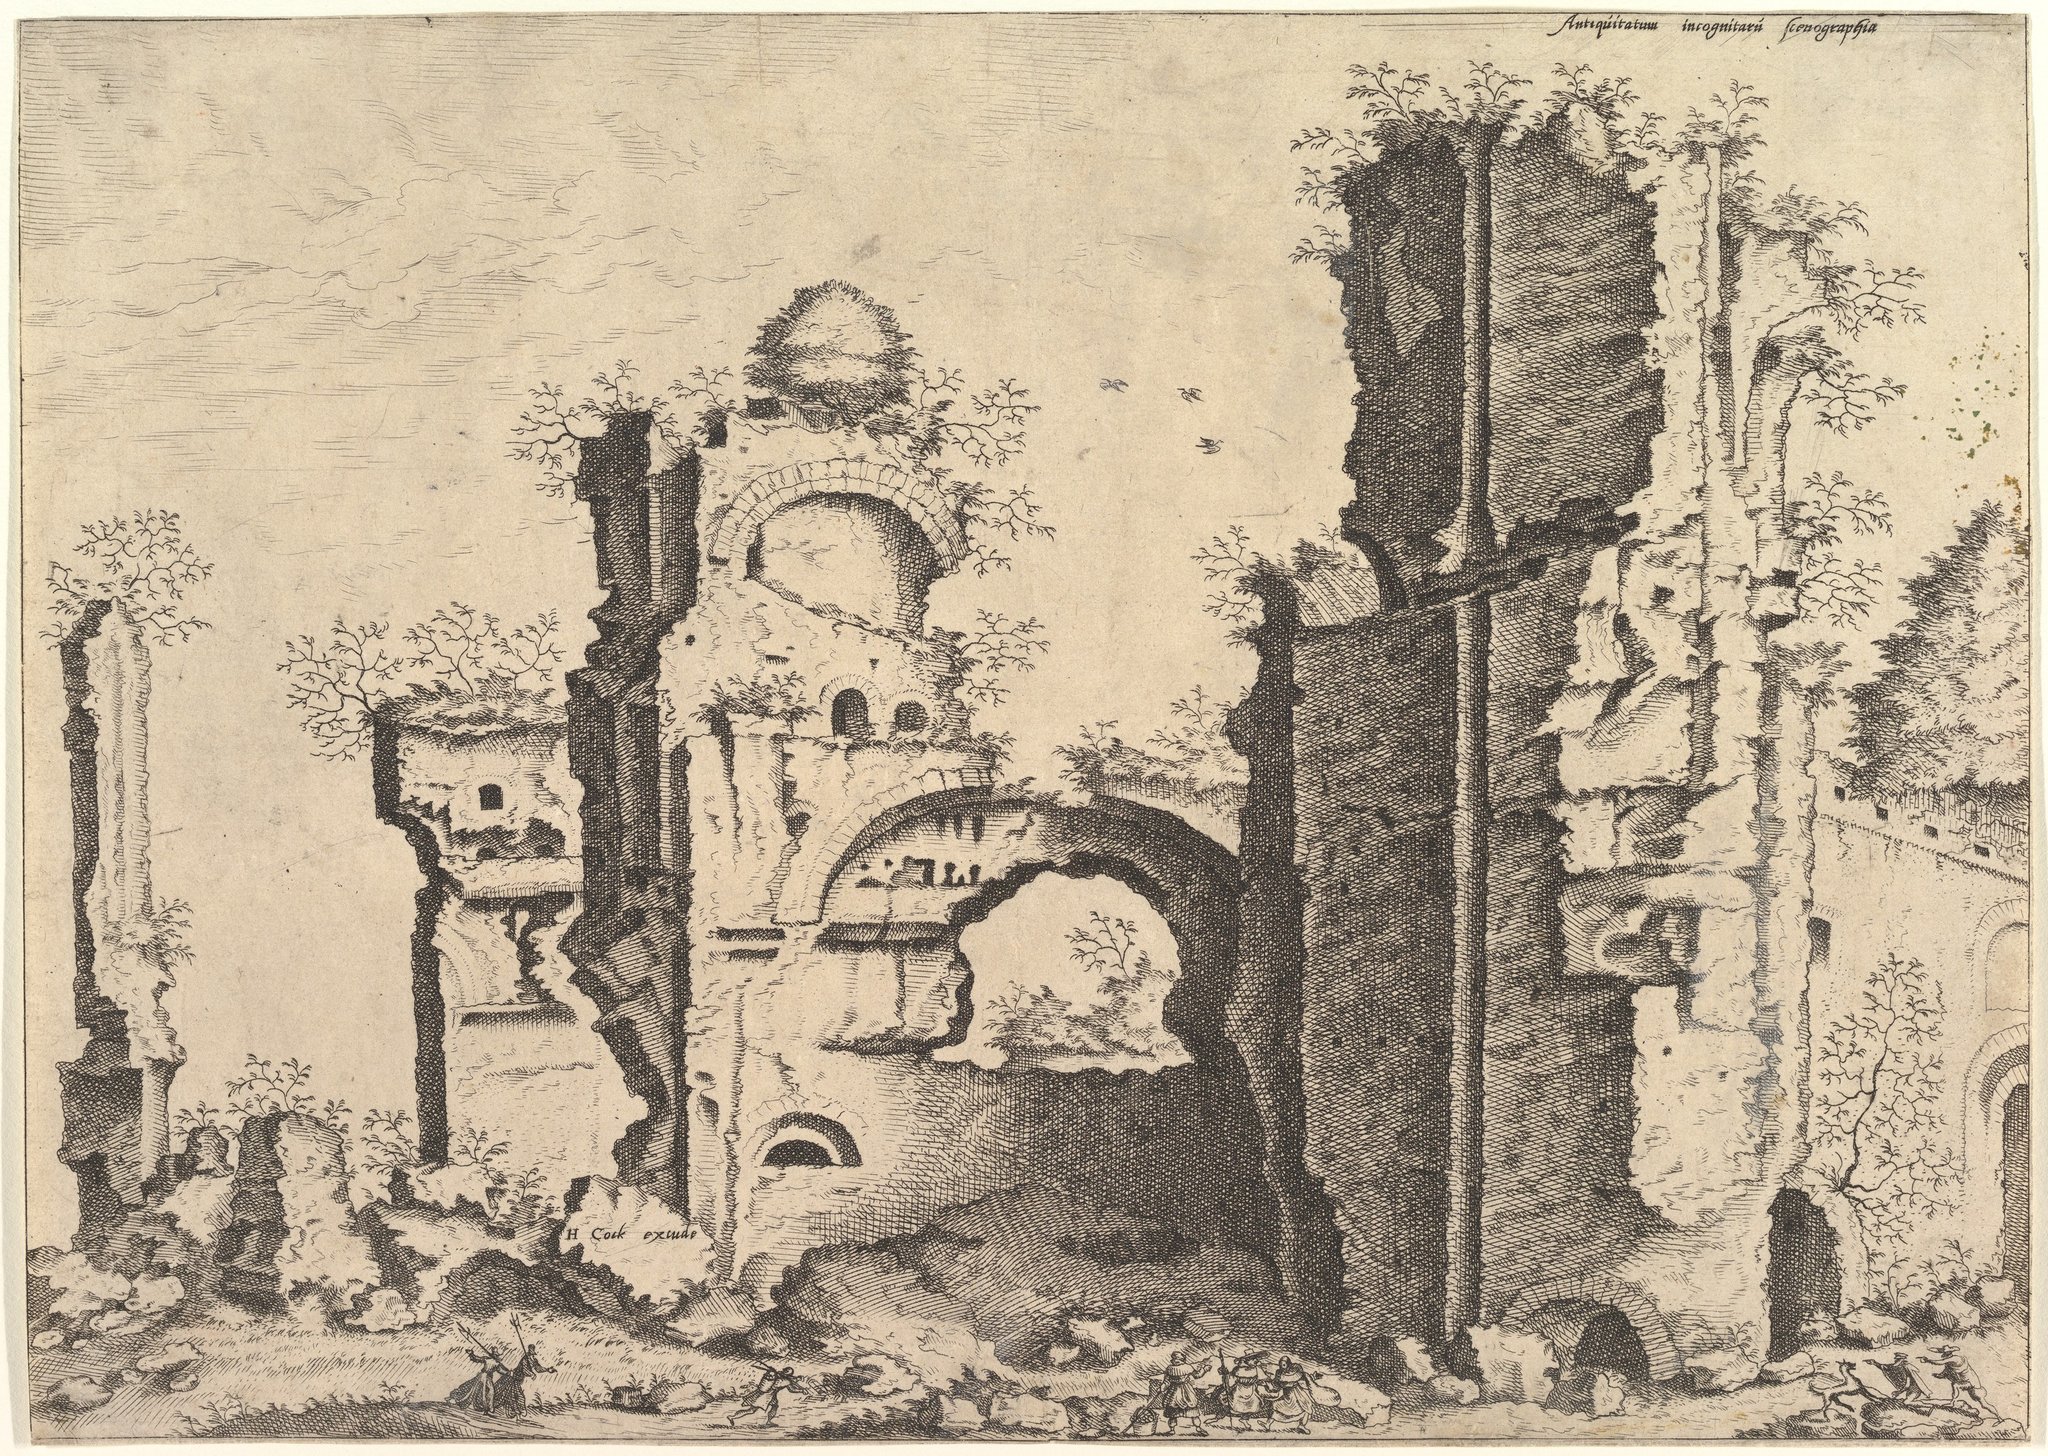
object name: print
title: View of ruins, possibly the Baths of Caracalla, from "The Small book of Roman ruins and buildings" (Operum antiquorum romanorum)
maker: hieronymus cock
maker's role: artist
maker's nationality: netherlandish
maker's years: 1510-1570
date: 1561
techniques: engraving, etching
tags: ruins